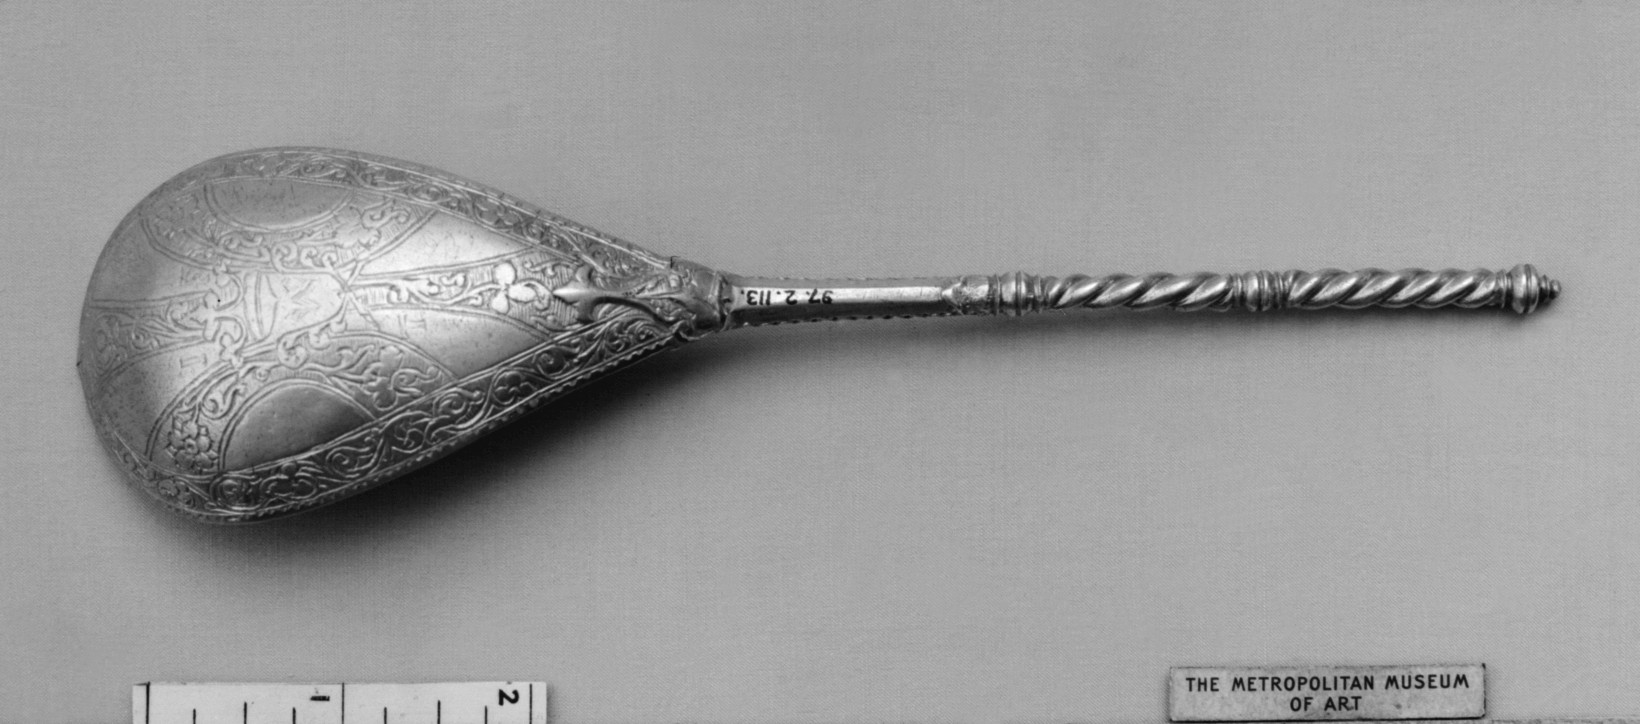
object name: spoon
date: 1601-1700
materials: gilt, silver